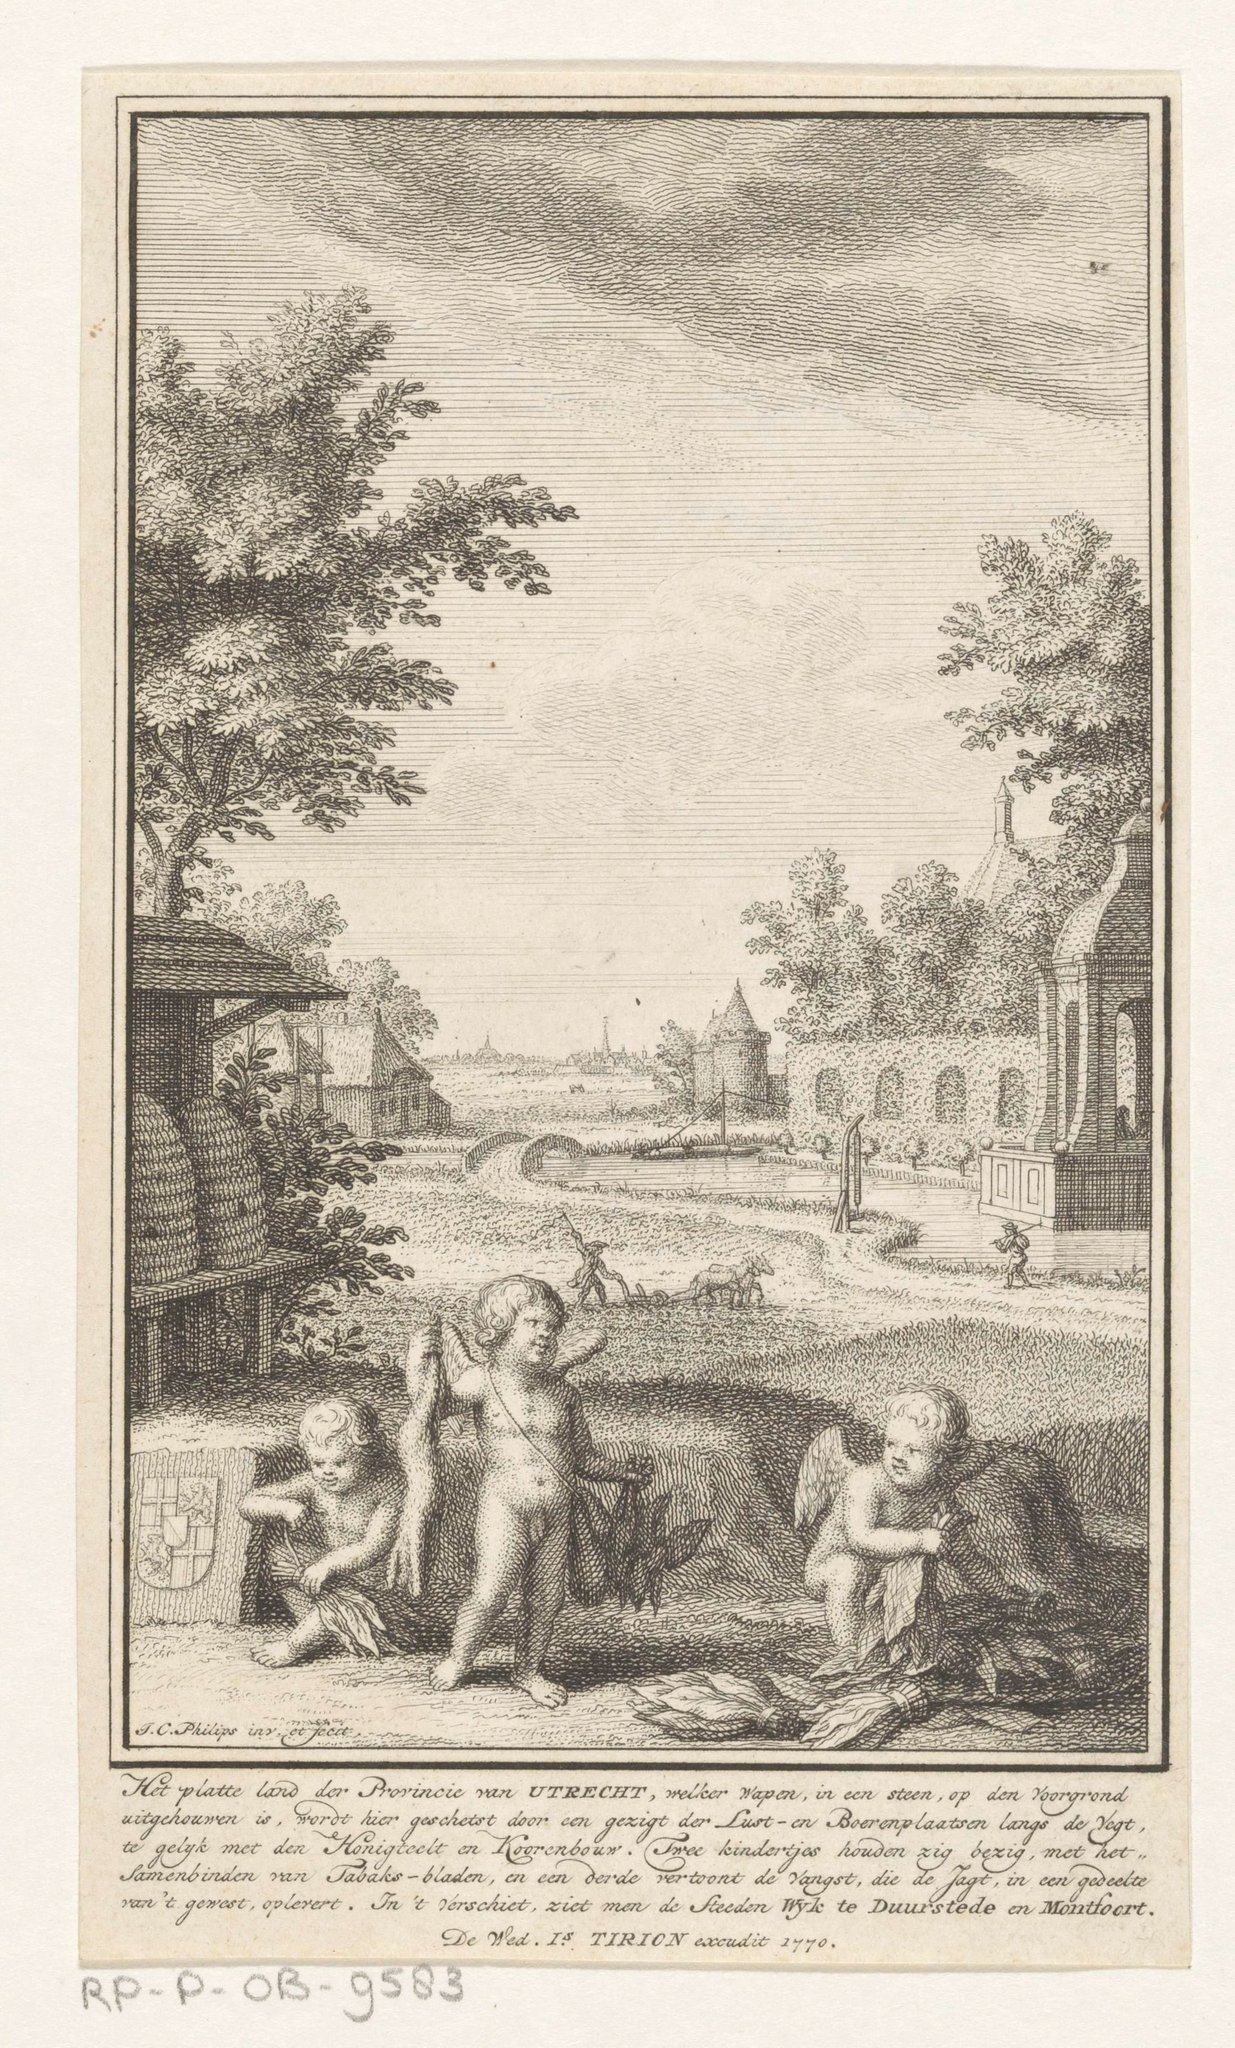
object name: print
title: Allegorie op de provincie Utrecht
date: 1770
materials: paper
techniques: engraving, etching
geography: amsterdam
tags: landscapes, cupids: 'amores', 'amoretti', 'putti', wijk bij duurstede, utrecht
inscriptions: collector's mark: Lugt 2228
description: Gezicht op de landelijke omgeving langs de rivier de Vecht in de provincie Utrecht. Drie putti met tabaksbladeren en een jachtbuit staan in de voorgrond naast het wapen van Utrecht. Links achter hen twee bijenkorven. In de achtergrond de steden Wijk bij Duurstede en Montfoort. In de ondermarge een vijfregelige Nederlandse tekst.